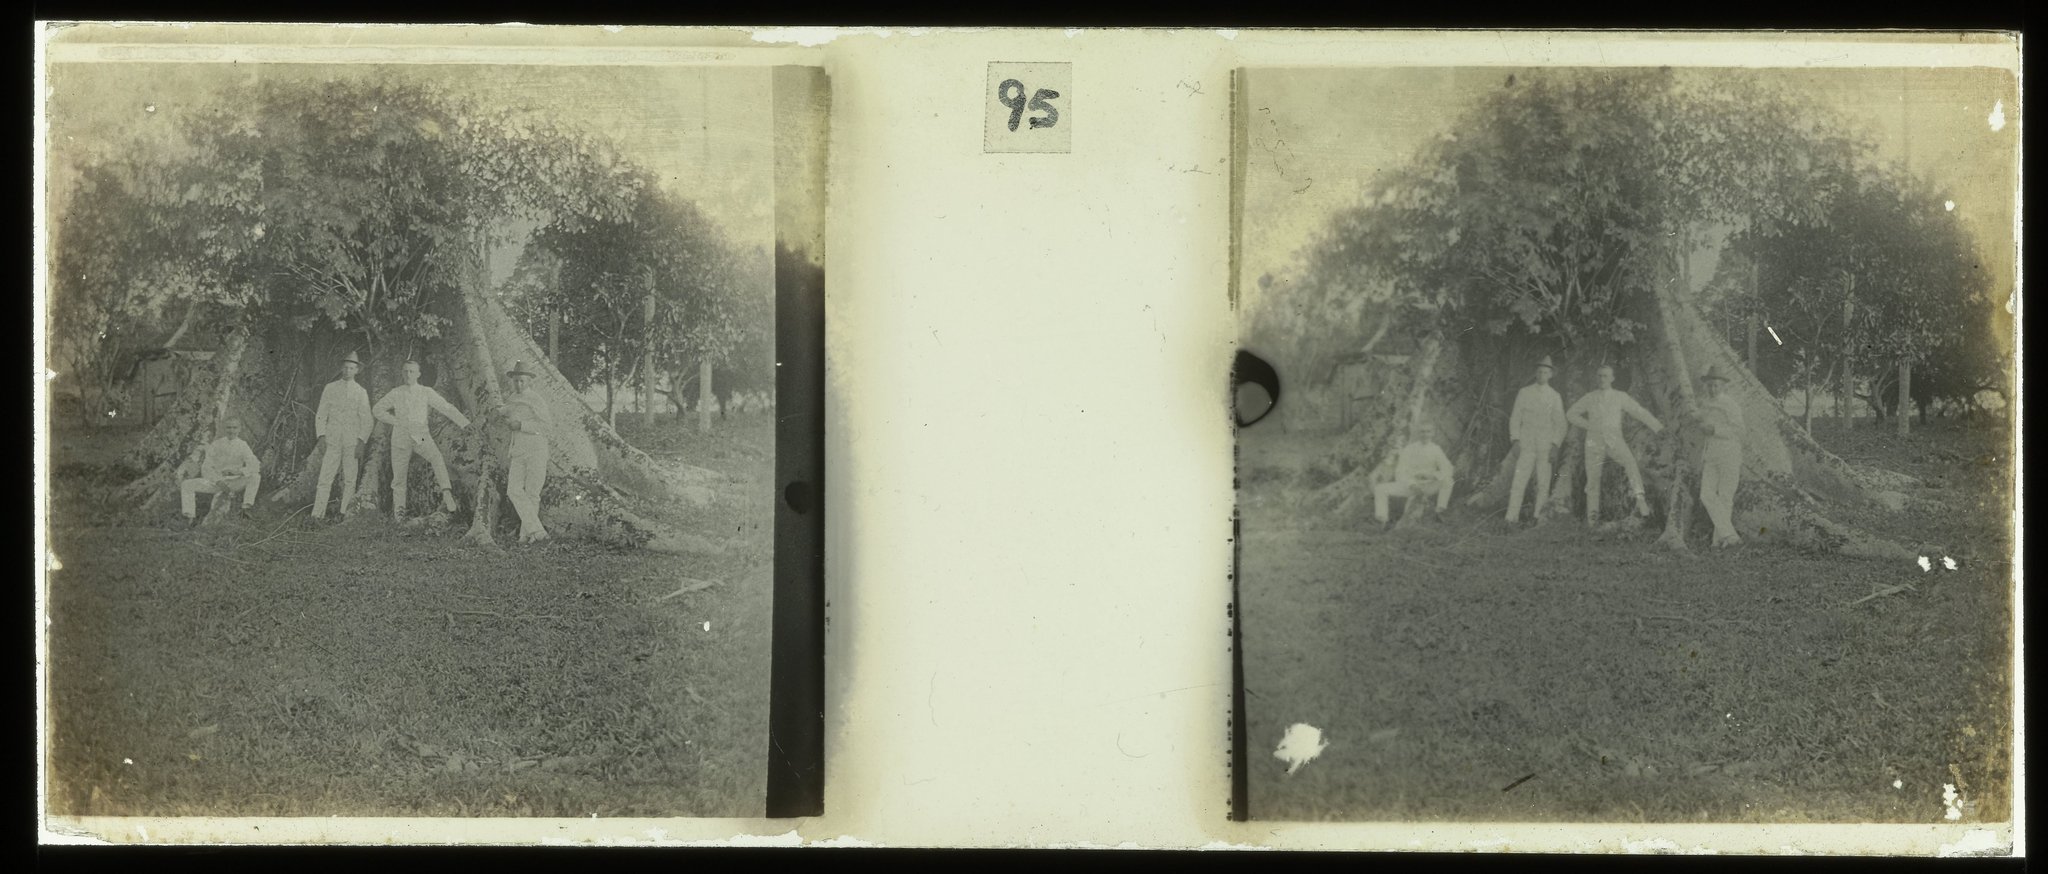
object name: stereograph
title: Plantage Accaribo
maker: theodoor brouwers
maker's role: amateurfotograaf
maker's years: 1874-1932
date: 1913-1930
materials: glass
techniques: photography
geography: suriname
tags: theodoor brouwers, plantation, suriname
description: In de periode 1911-1932 woonde op plantage Accaribo in Suriname de familie Brouwers van wie de foto's afkomstig zijn. Rond 1910 vond Theodoor Brouwers werk op plantage Accaribo. In 1929 werd hij eigenaar van de plantage. Op Accaribo werden in zijn tijd bananen geproduceerd en wat koffie.